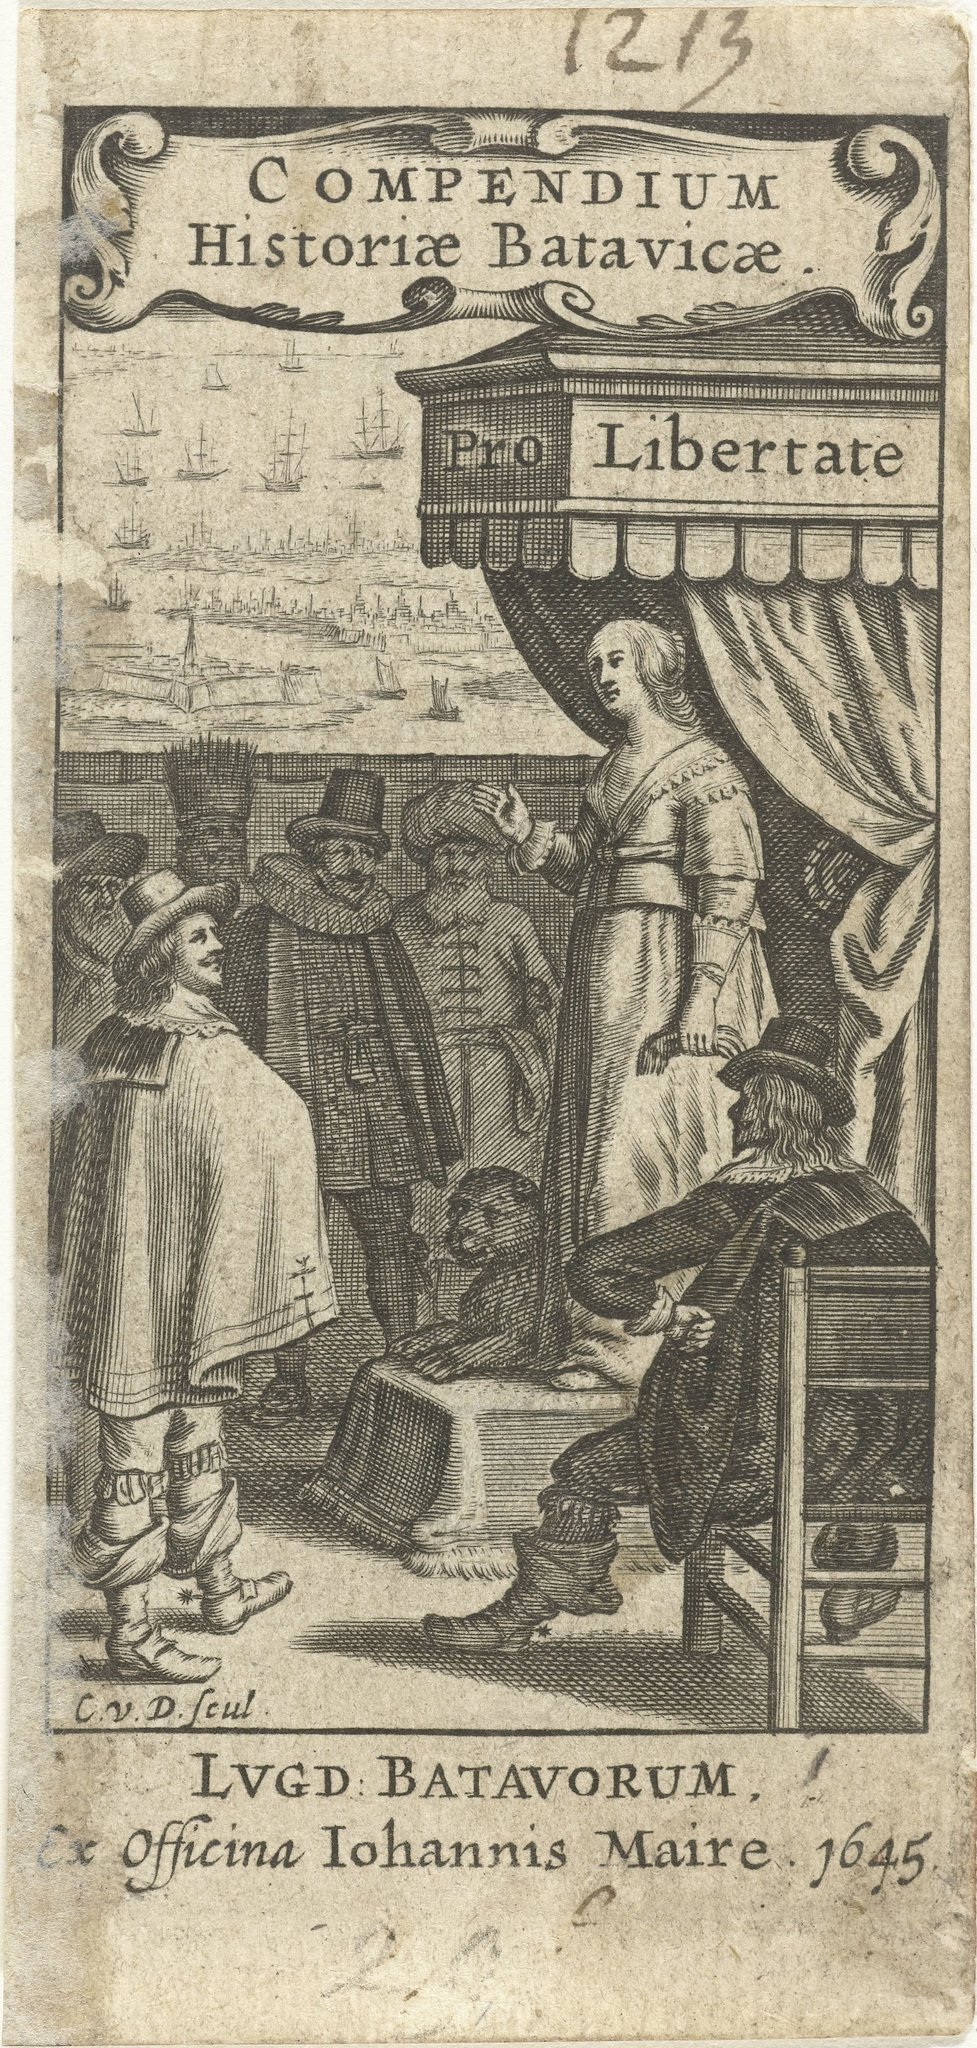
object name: print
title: Titelpagina voor: Compendium historiæ Batavicæ, a Julio Cæsare usque ad hæc tempora, Leiden 1645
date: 1645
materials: paper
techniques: engraving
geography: amsterdam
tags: symbols of particular nations, states, districts, etc.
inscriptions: collector's mark: Lugt 2228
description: Titelpagina voor: Antonius Thysius jr., Compendium historiæ Batavicæ, a Julio Cæsare usque ad hæc tempora Joannes Maire (uitgever), Leiden 1645